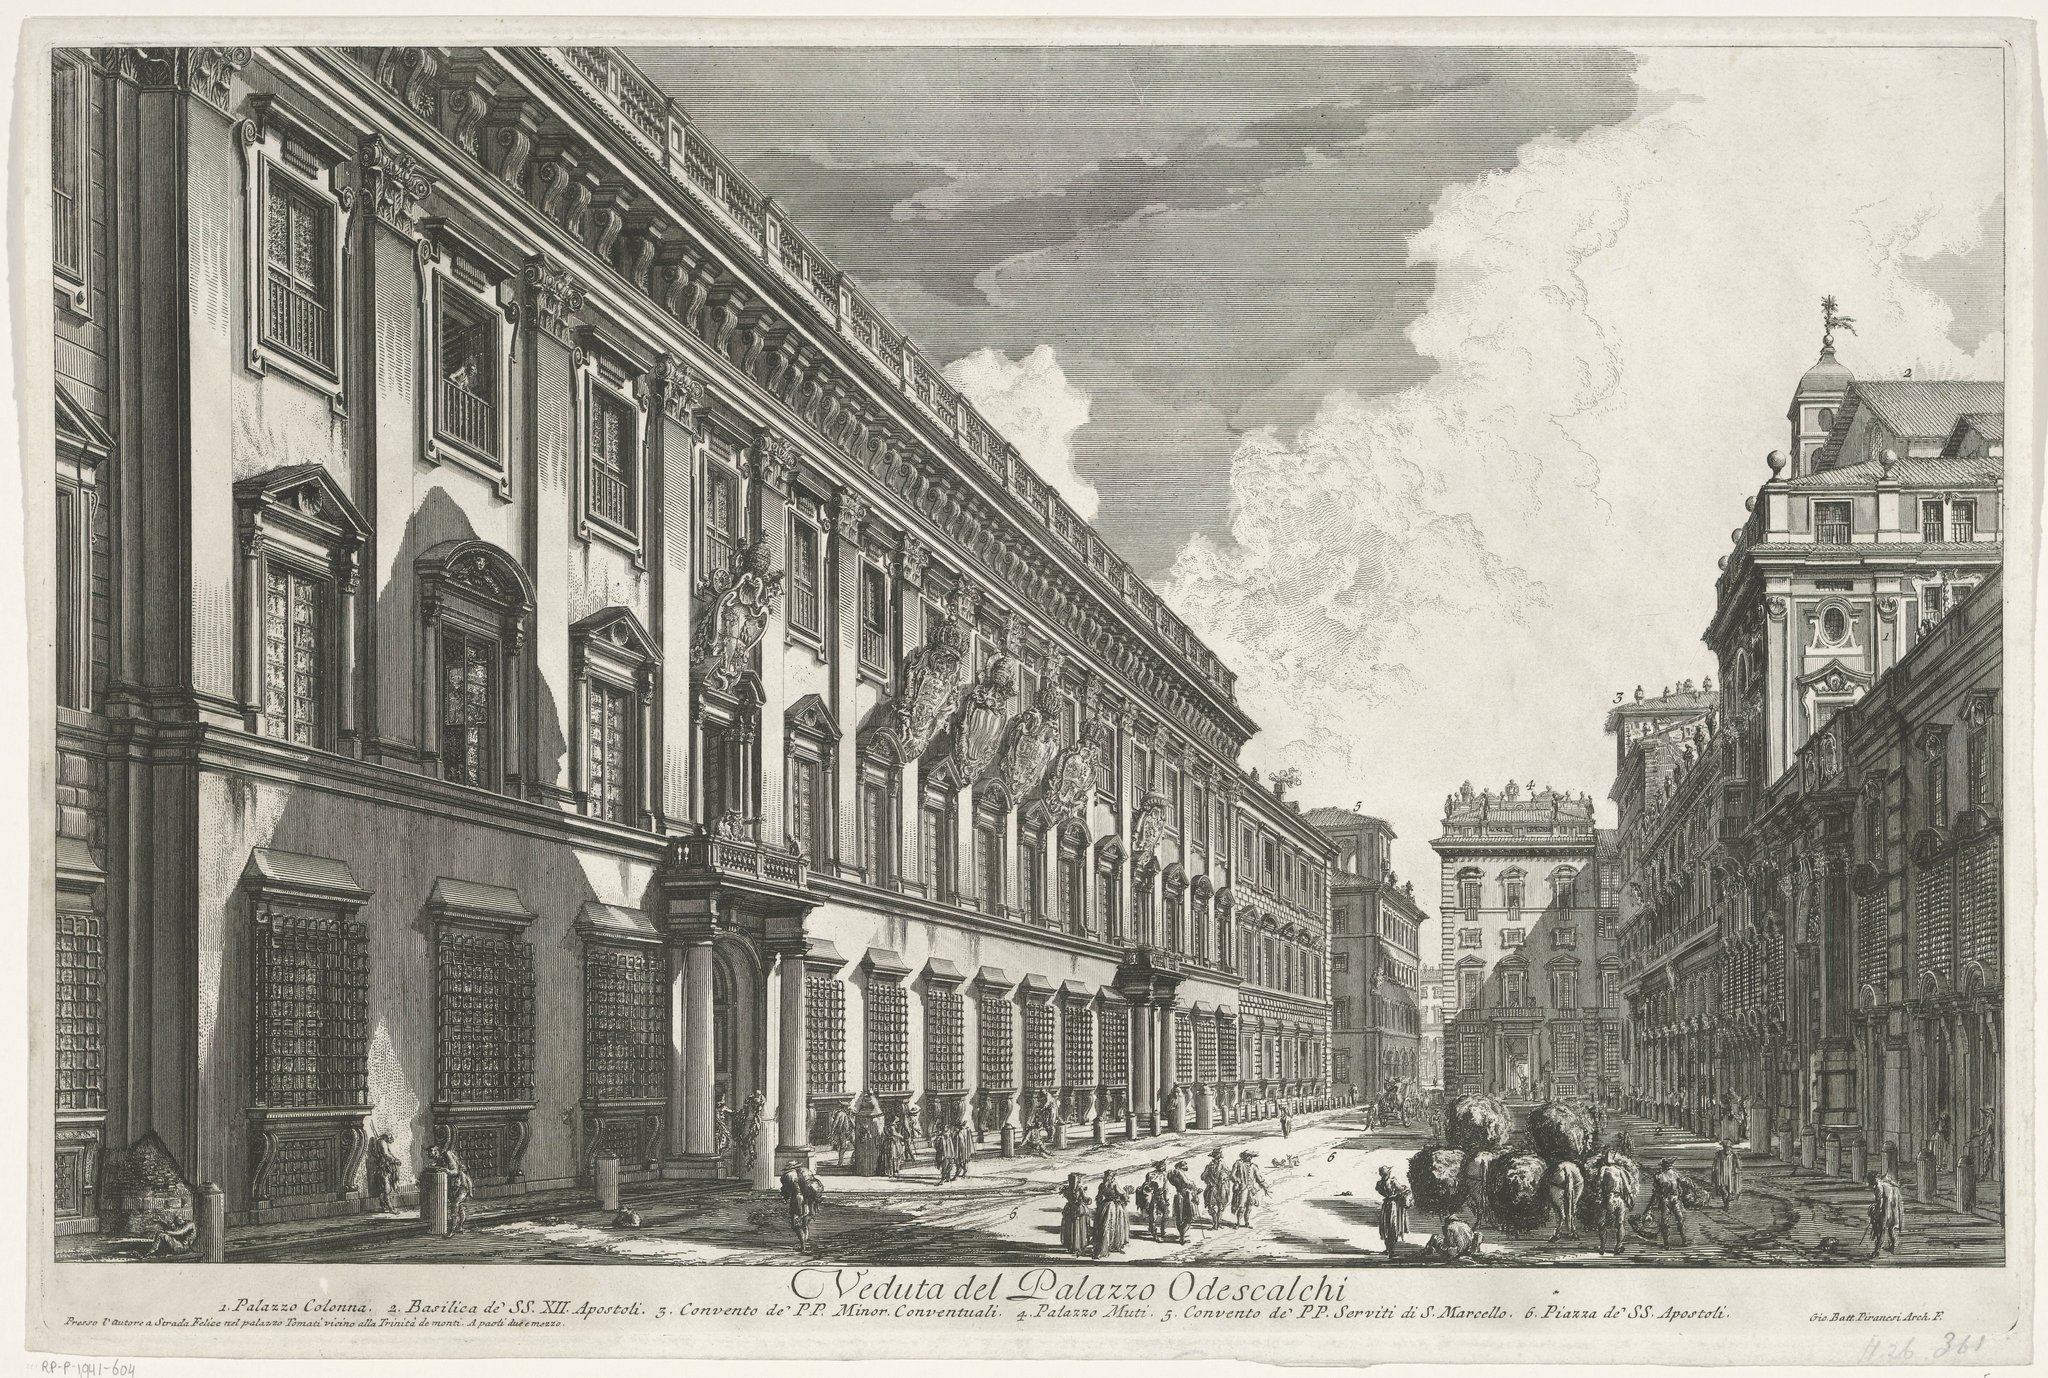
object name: print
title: Vedute di Roma disegnate ed incise da Giambattista Piranesi architetto Ve(nez)iano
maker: giovanni battista piranesi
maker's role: designer, draughtsman, print maker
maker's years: 1720-1778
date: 1748-1778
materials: paper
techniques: etching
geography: rome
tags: hôtel, i.e. small palace in city, rome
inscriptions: collector's mark: Lugt 2228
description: Deze prent maakt deel uit van de serie 'Vedute di Roma'. Piranesi werkte aan deze 135 platen tellende serie tussen 1748 en zijn dood in 1778. Francesco Piranesi voegde later nog twee prenten toe aan de reeks van zijn vader.